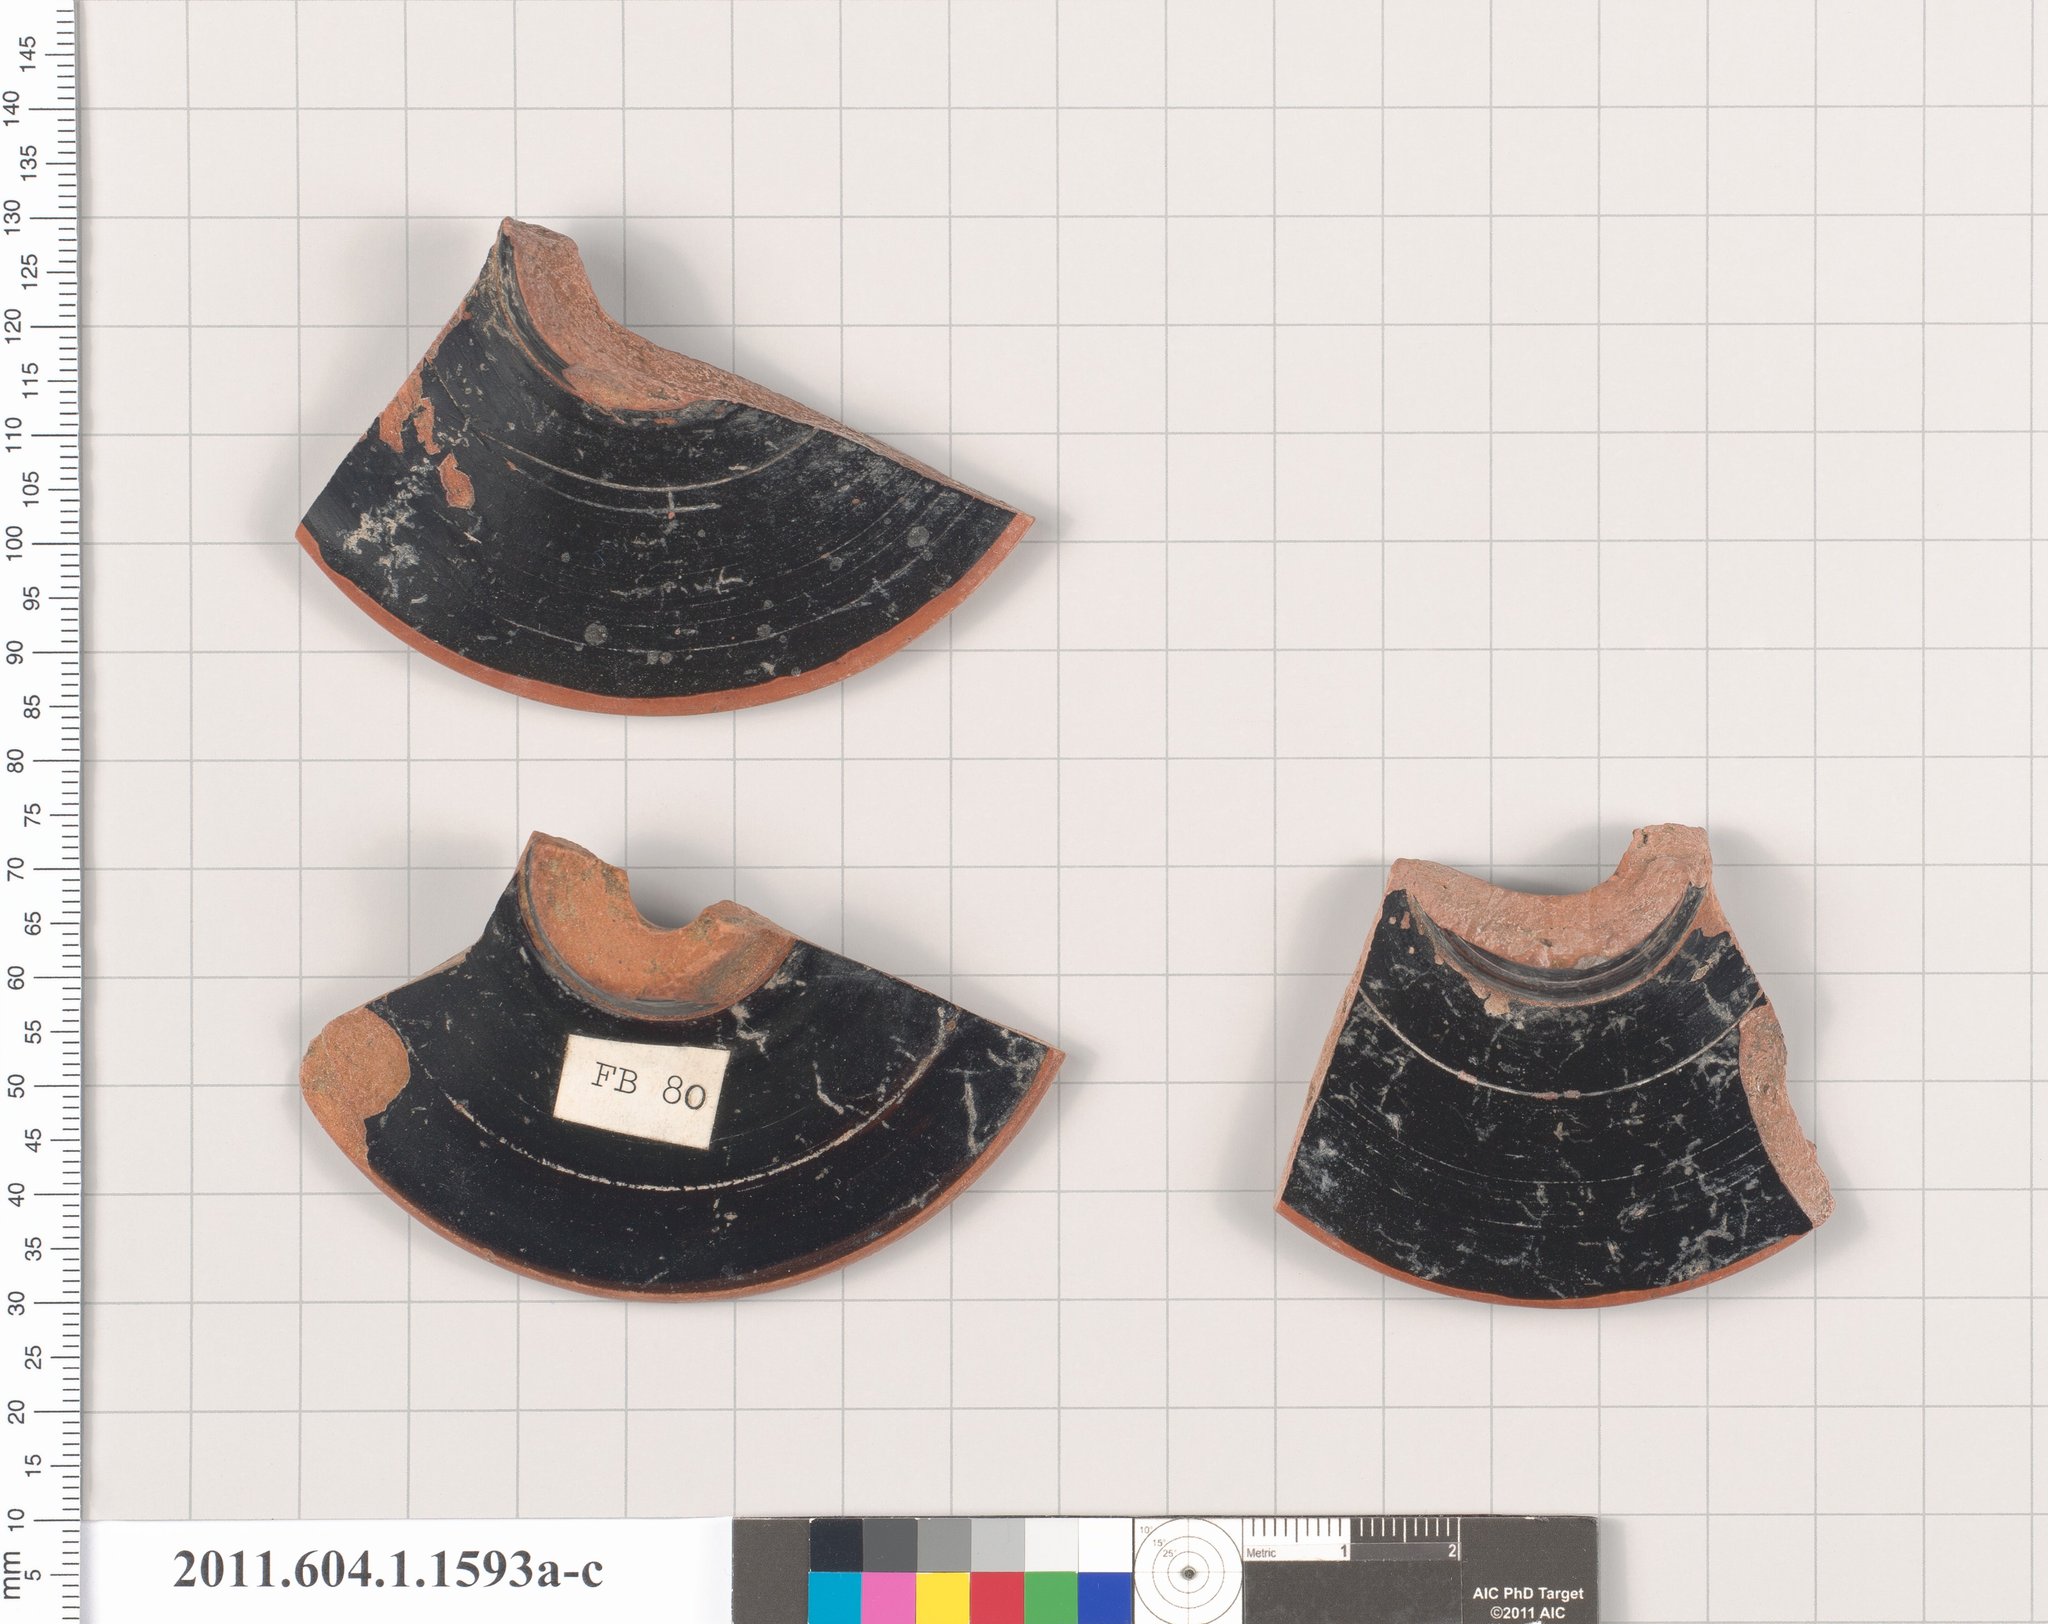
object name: kylix fragment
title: Terracotta fragments of kylikes (drinking cups)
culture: greek, attic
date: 500-401 BCE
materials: terracotta